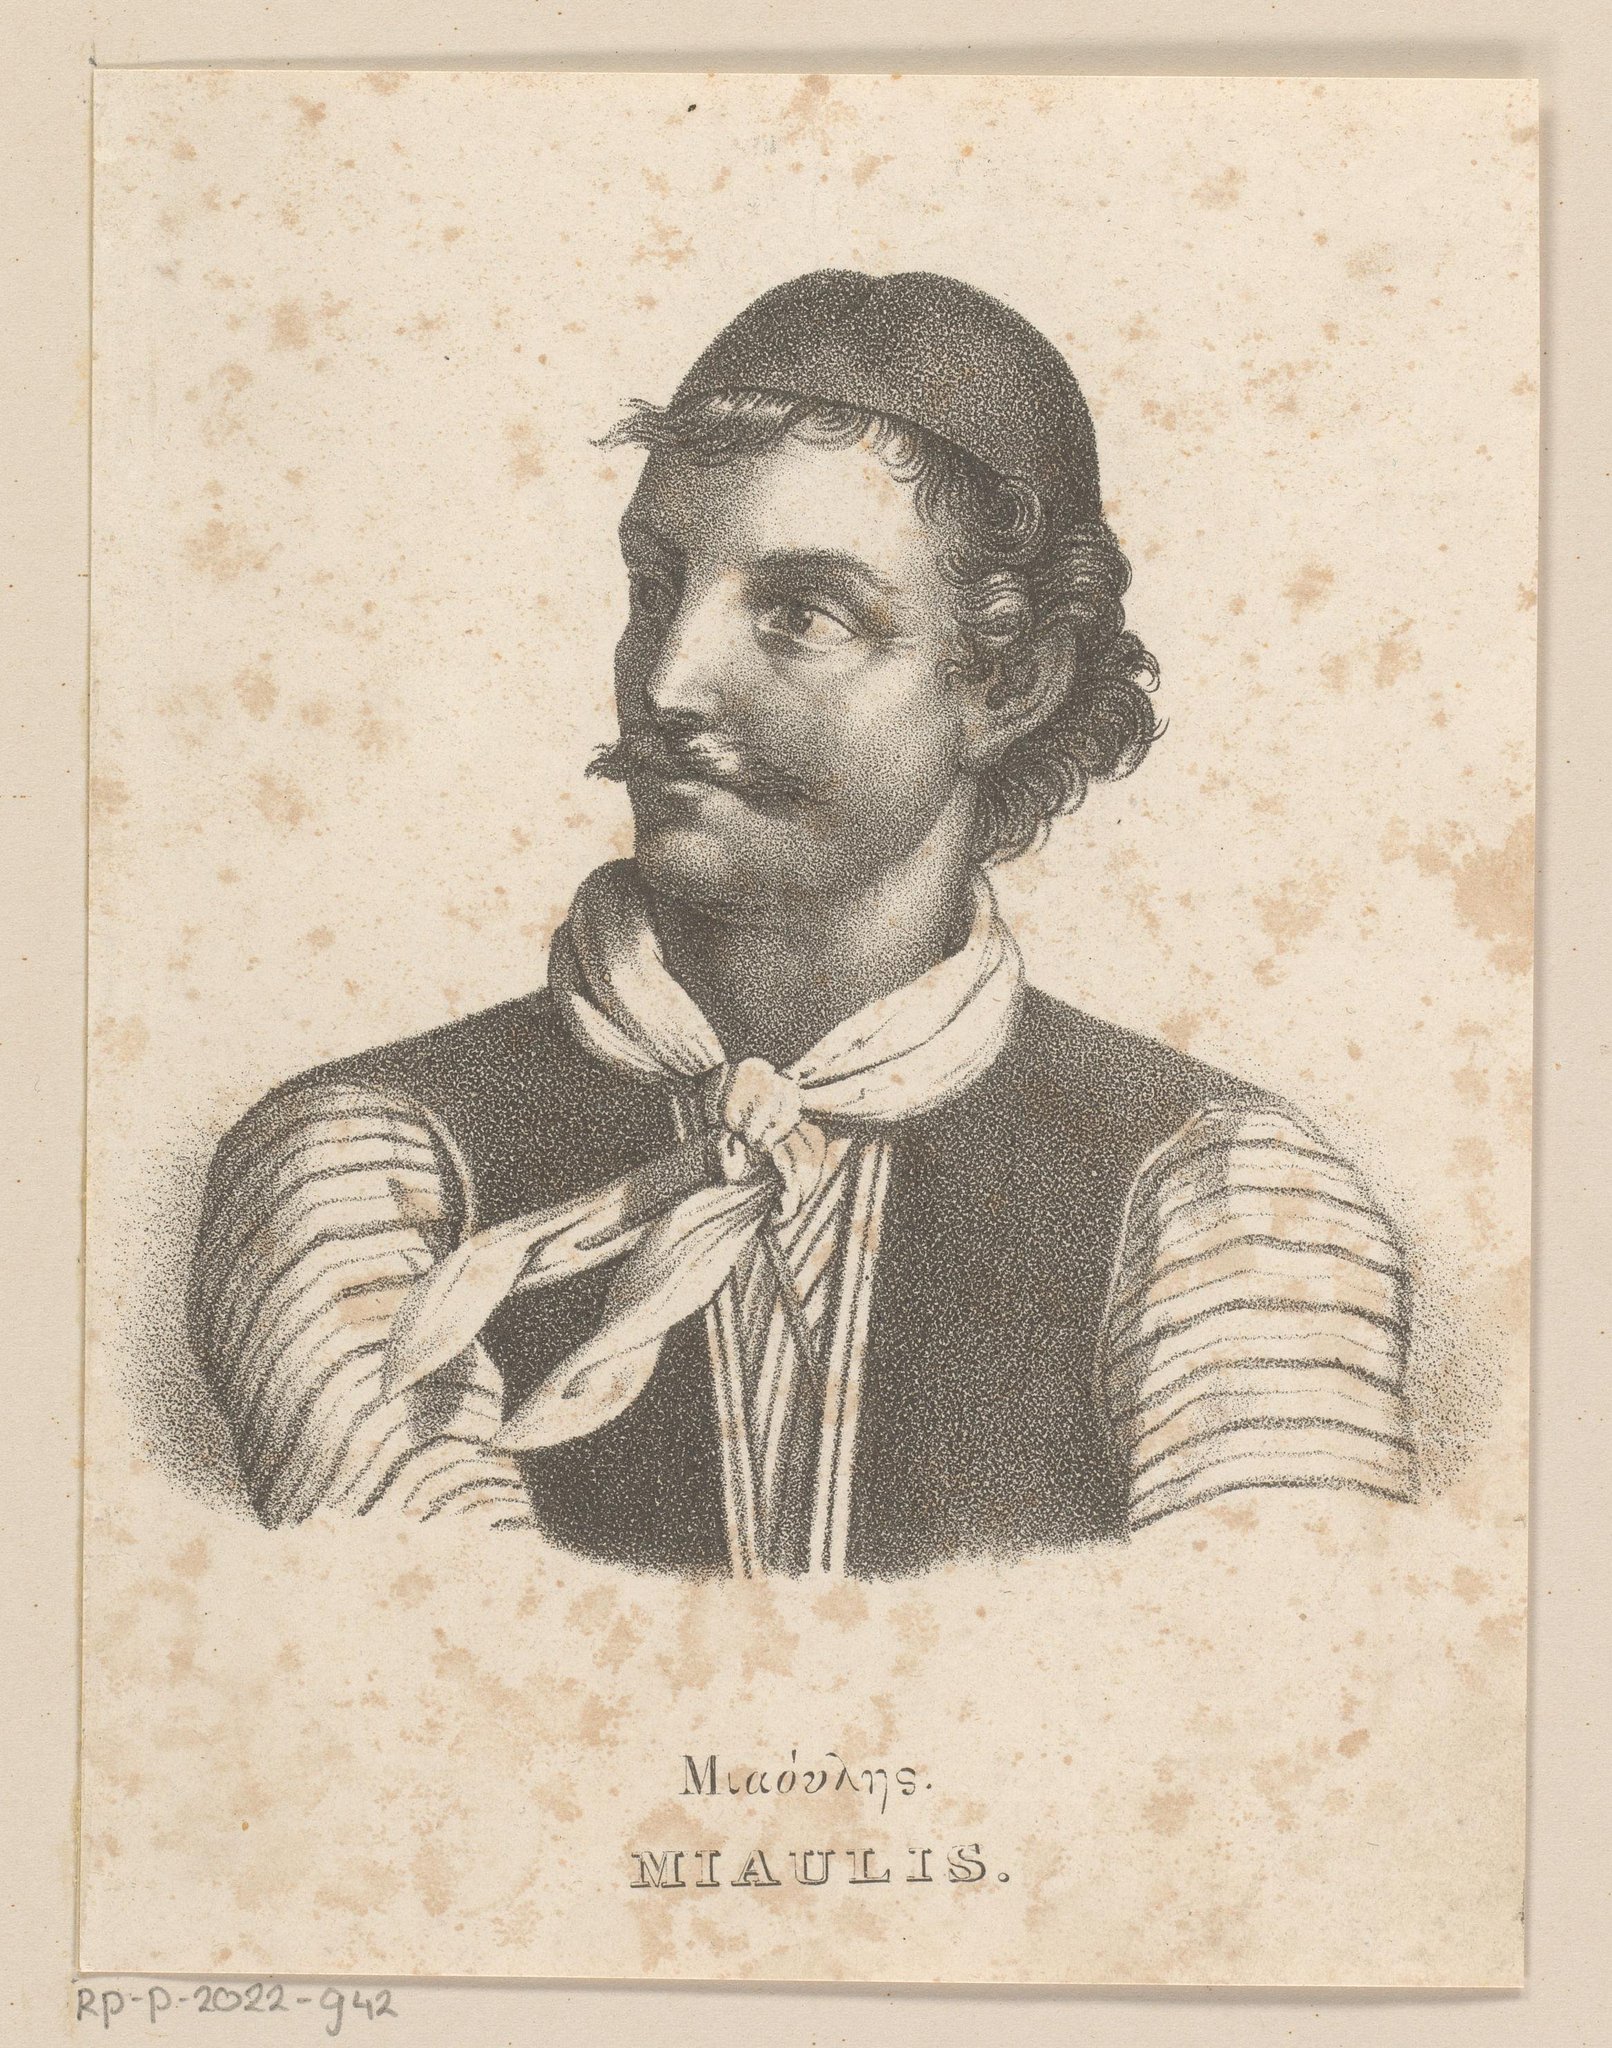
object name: print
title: Miaulis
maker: Anonymous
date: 1800-1900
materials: paper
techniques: lithograph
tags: politician, adult man, historical persons